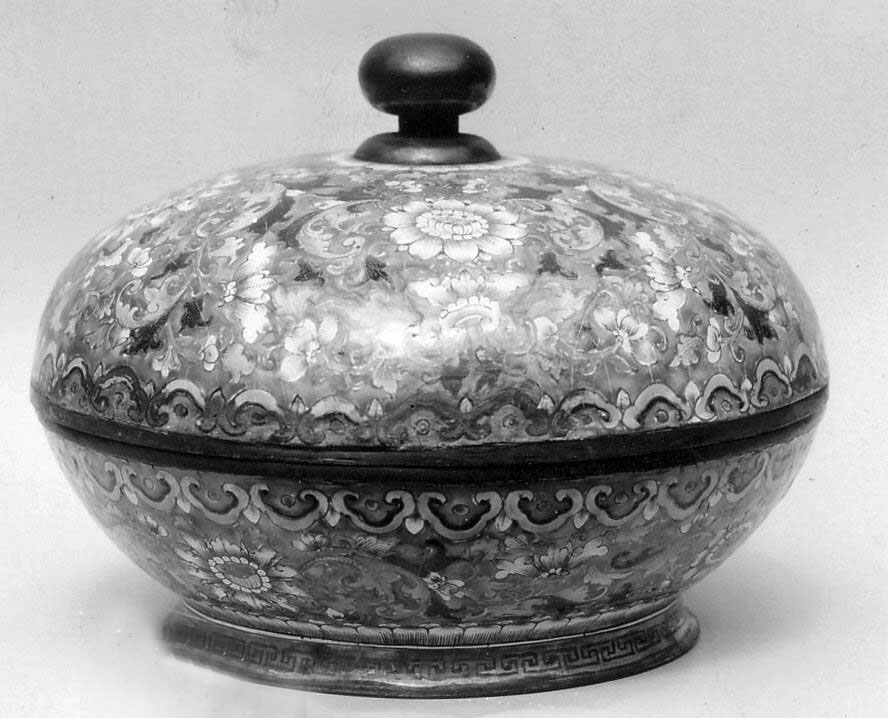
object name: covered bowl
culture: chinese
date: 1736-1795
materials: enamel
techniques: painting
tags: flowers,leaves